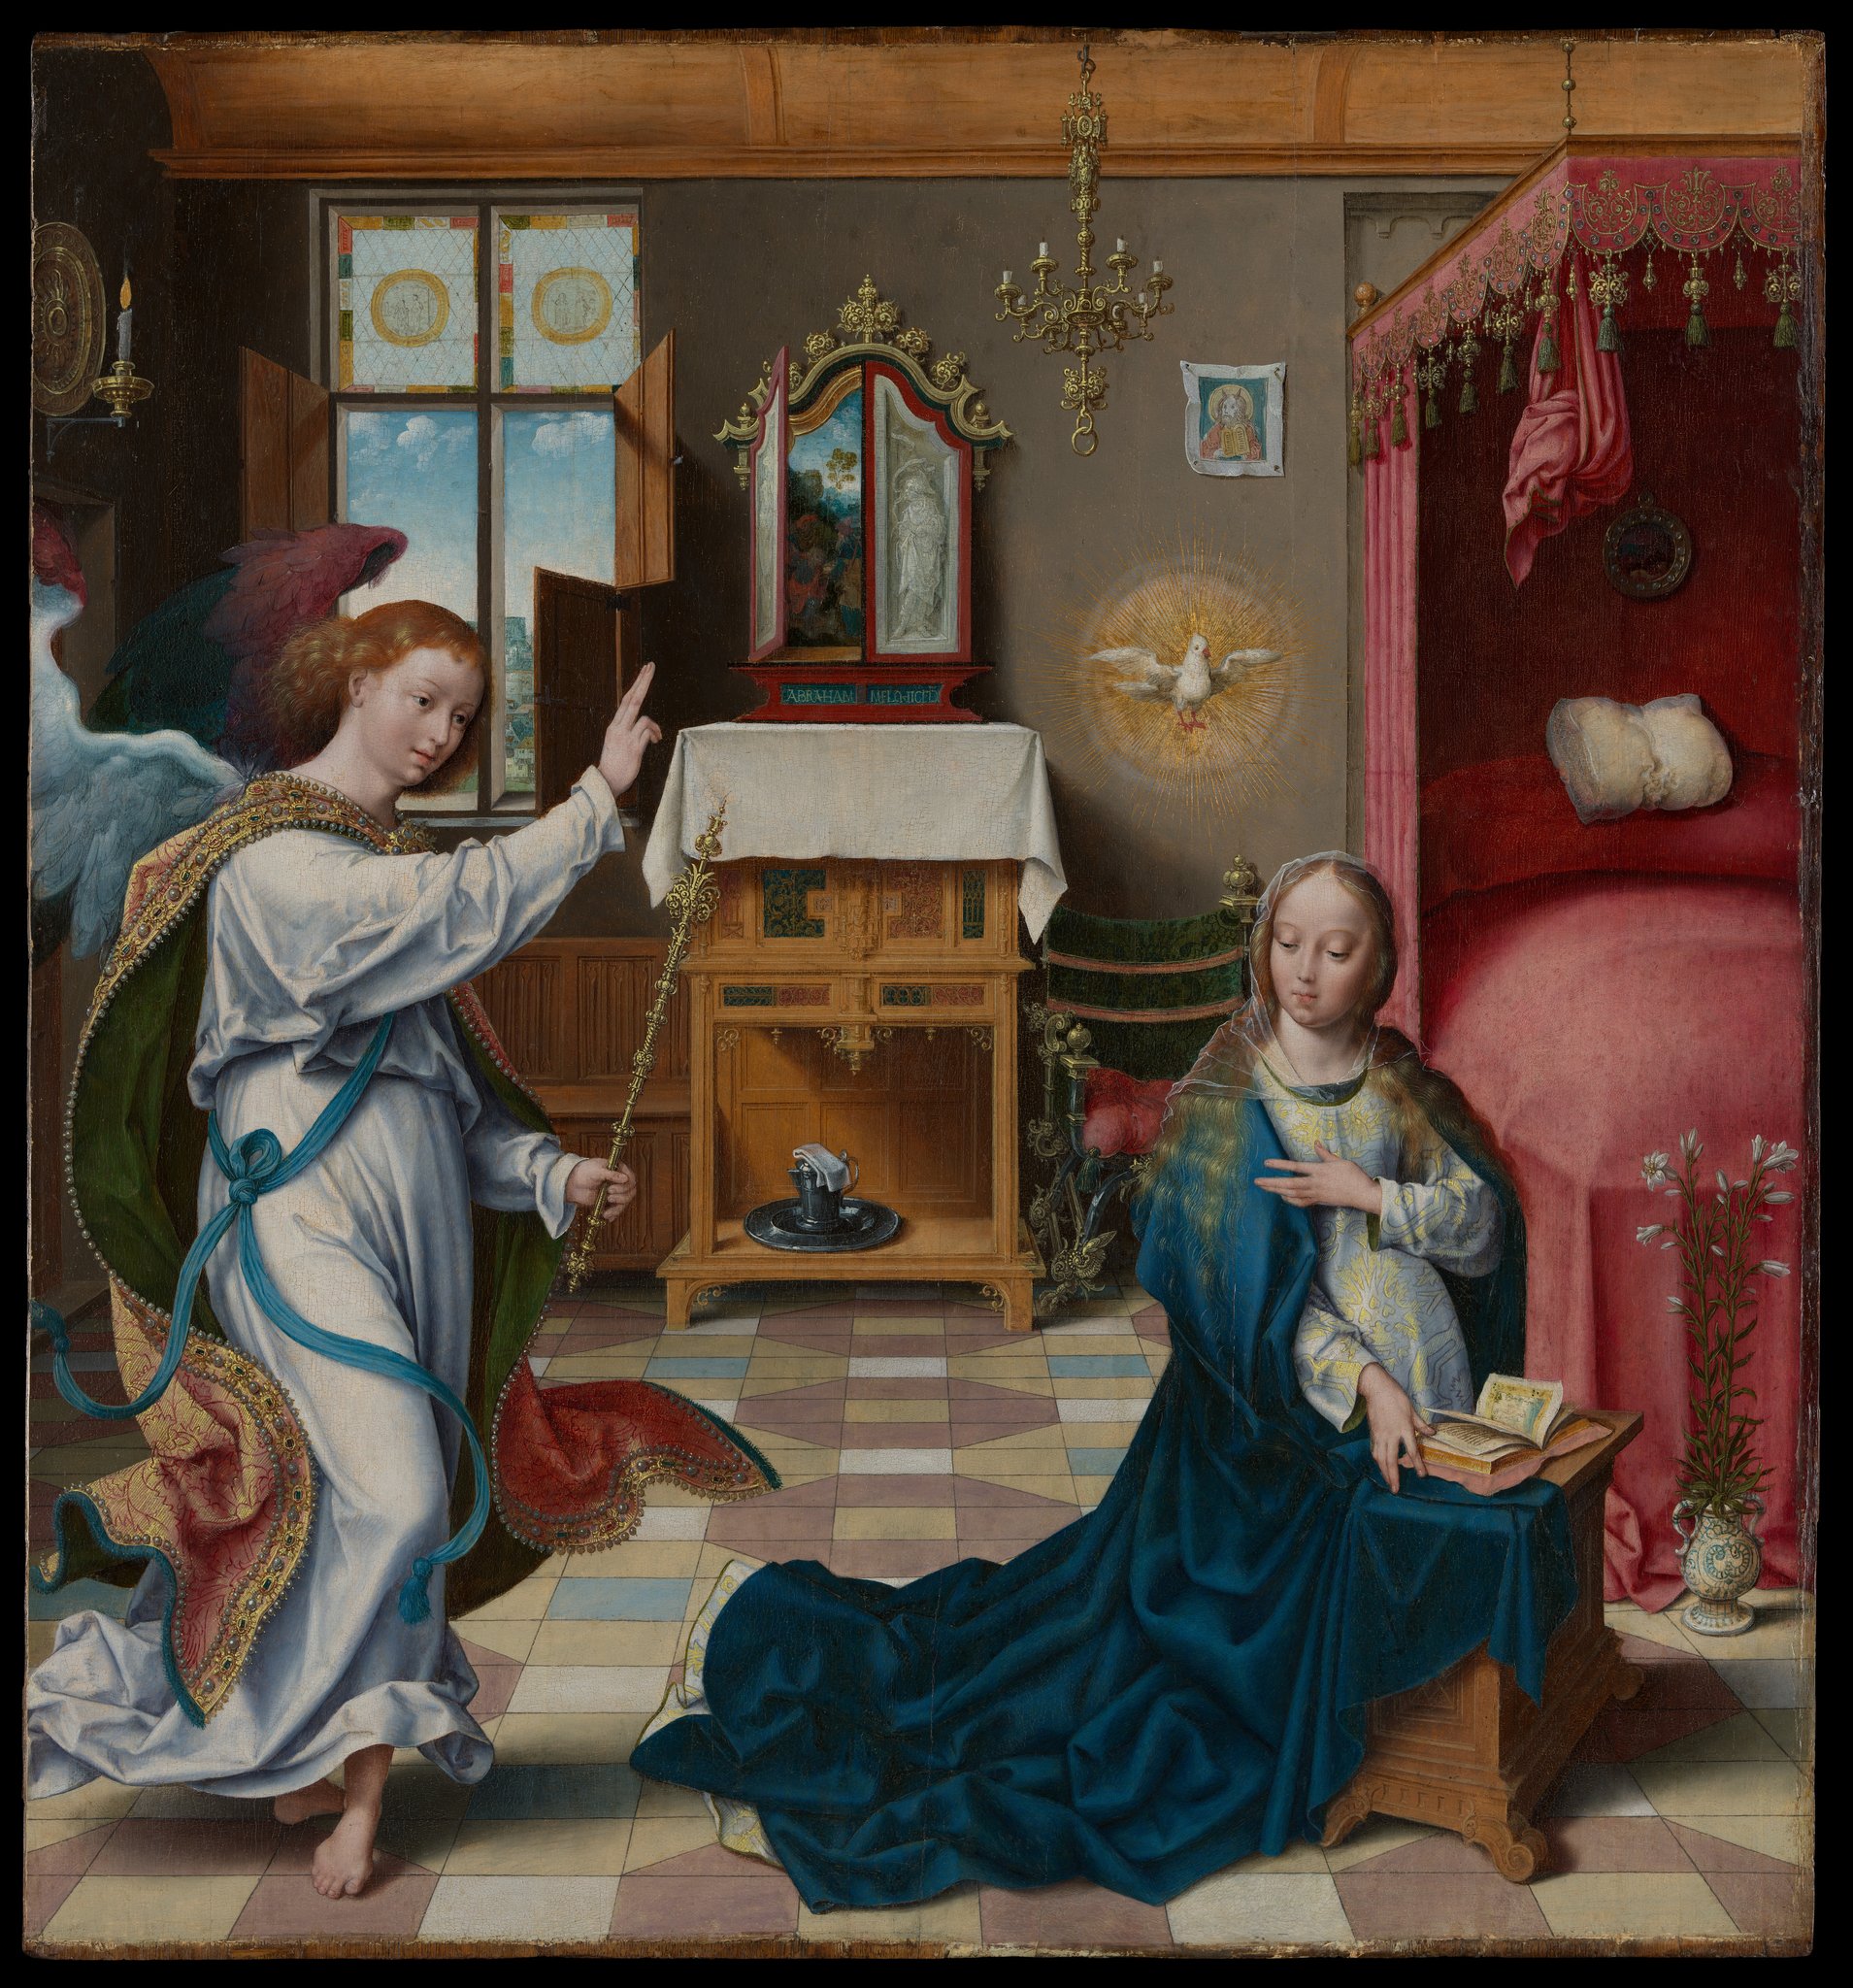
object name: painting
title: The Annunciation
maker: joos van cleve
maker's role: artist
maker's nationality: netherlandish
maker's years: 1485-1541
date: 1525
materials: oil, wood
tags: doves,bedrooms,virgin mary,archangel gabriel,annunciation,beds